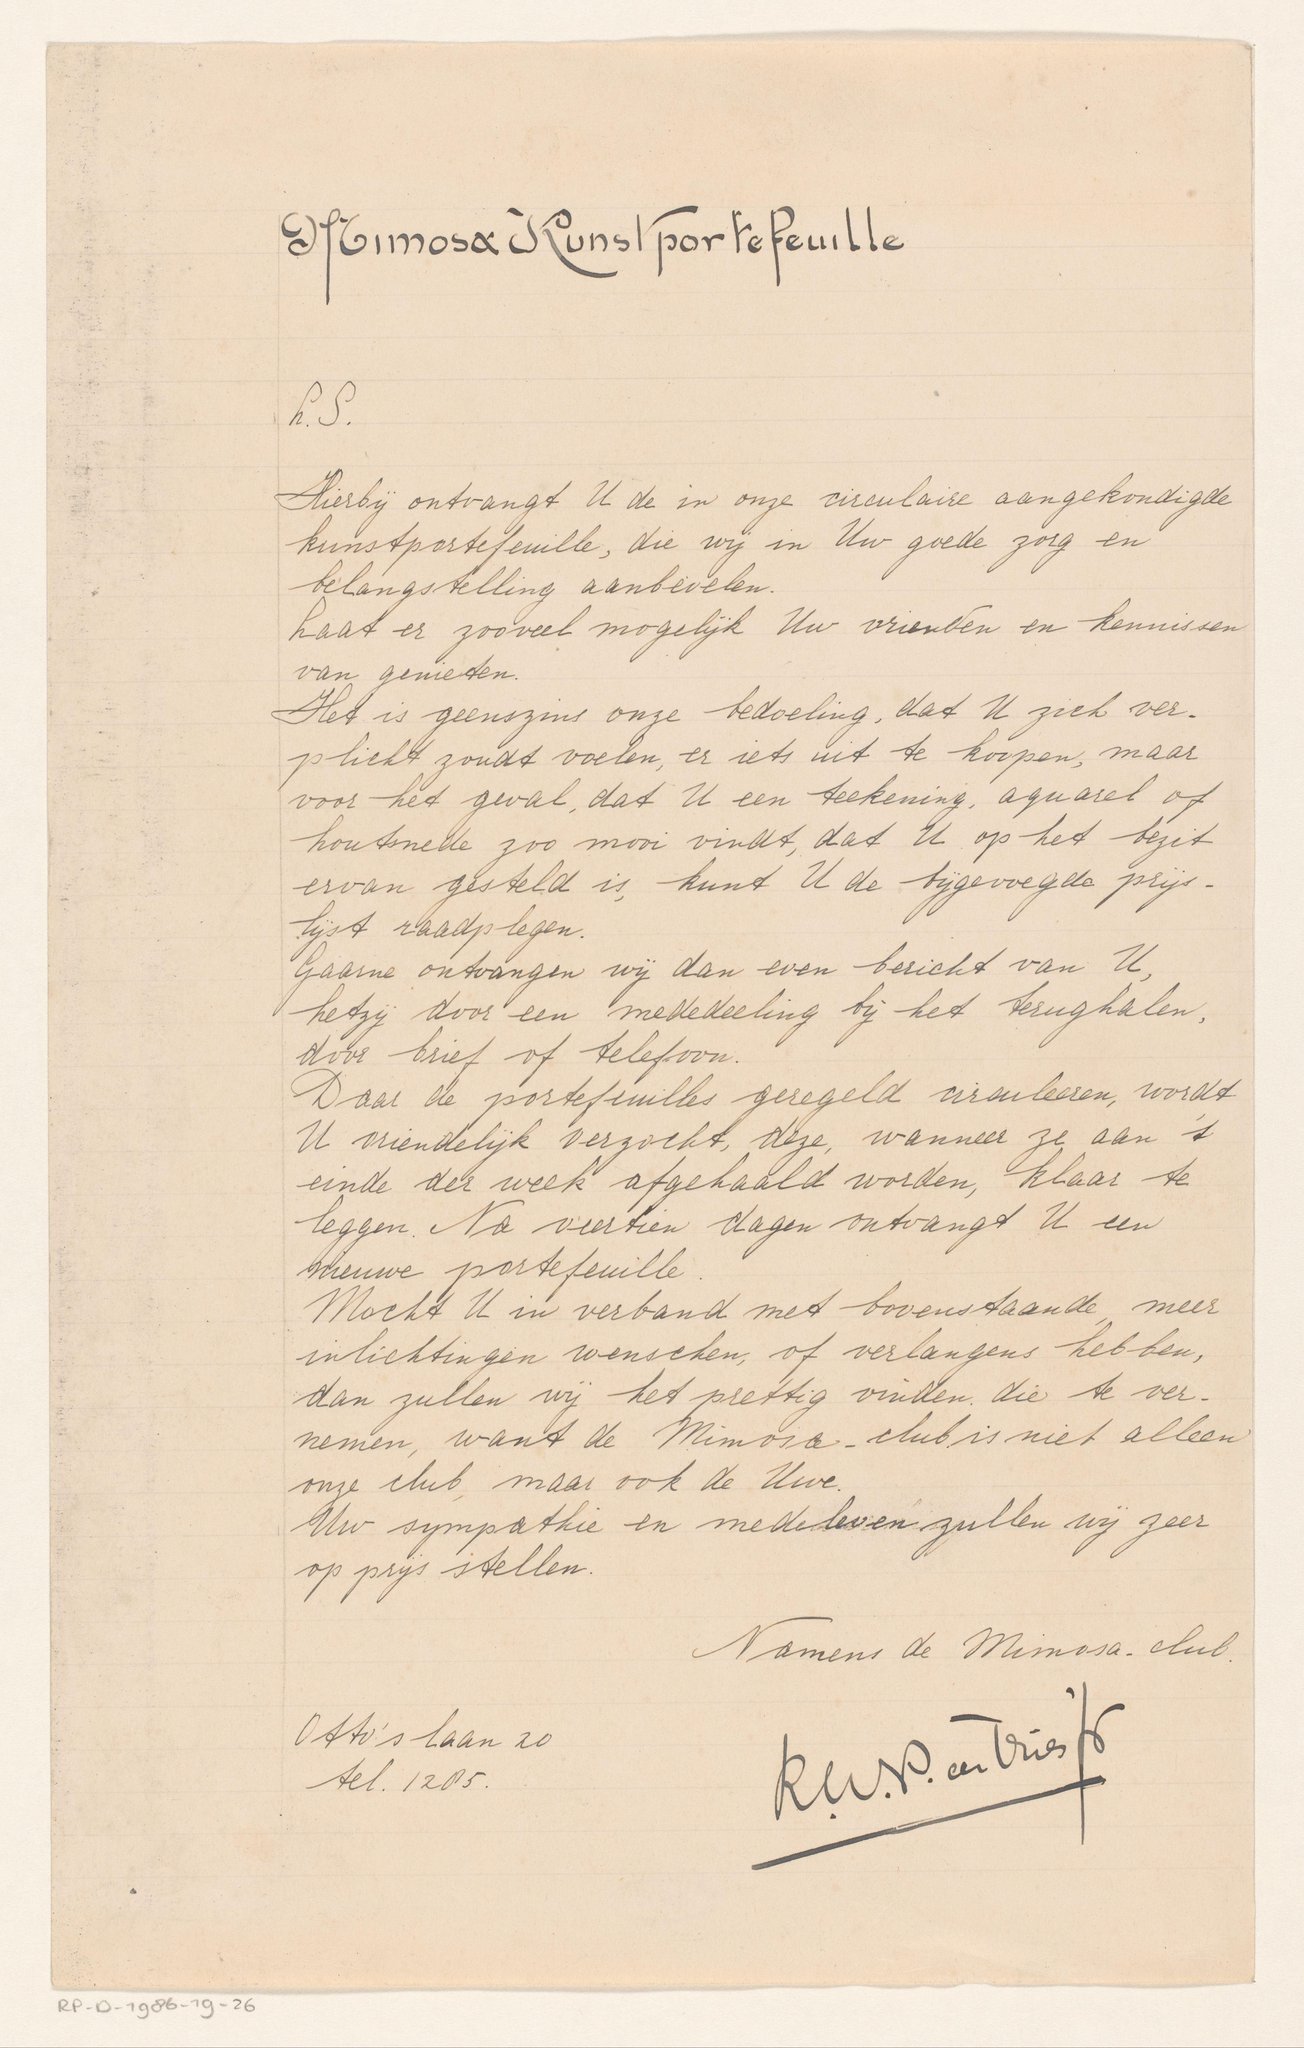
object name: letter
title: Brief aan anoniem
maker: reinier willem petrus de vries (1874-1953)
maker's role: draughtsman, print maker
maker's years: 1874-1953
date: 1884-1952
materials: ink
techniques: pen, writing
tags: painting, drawing and the graphic arts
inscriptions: collector's mark: ‘R:MVS.’